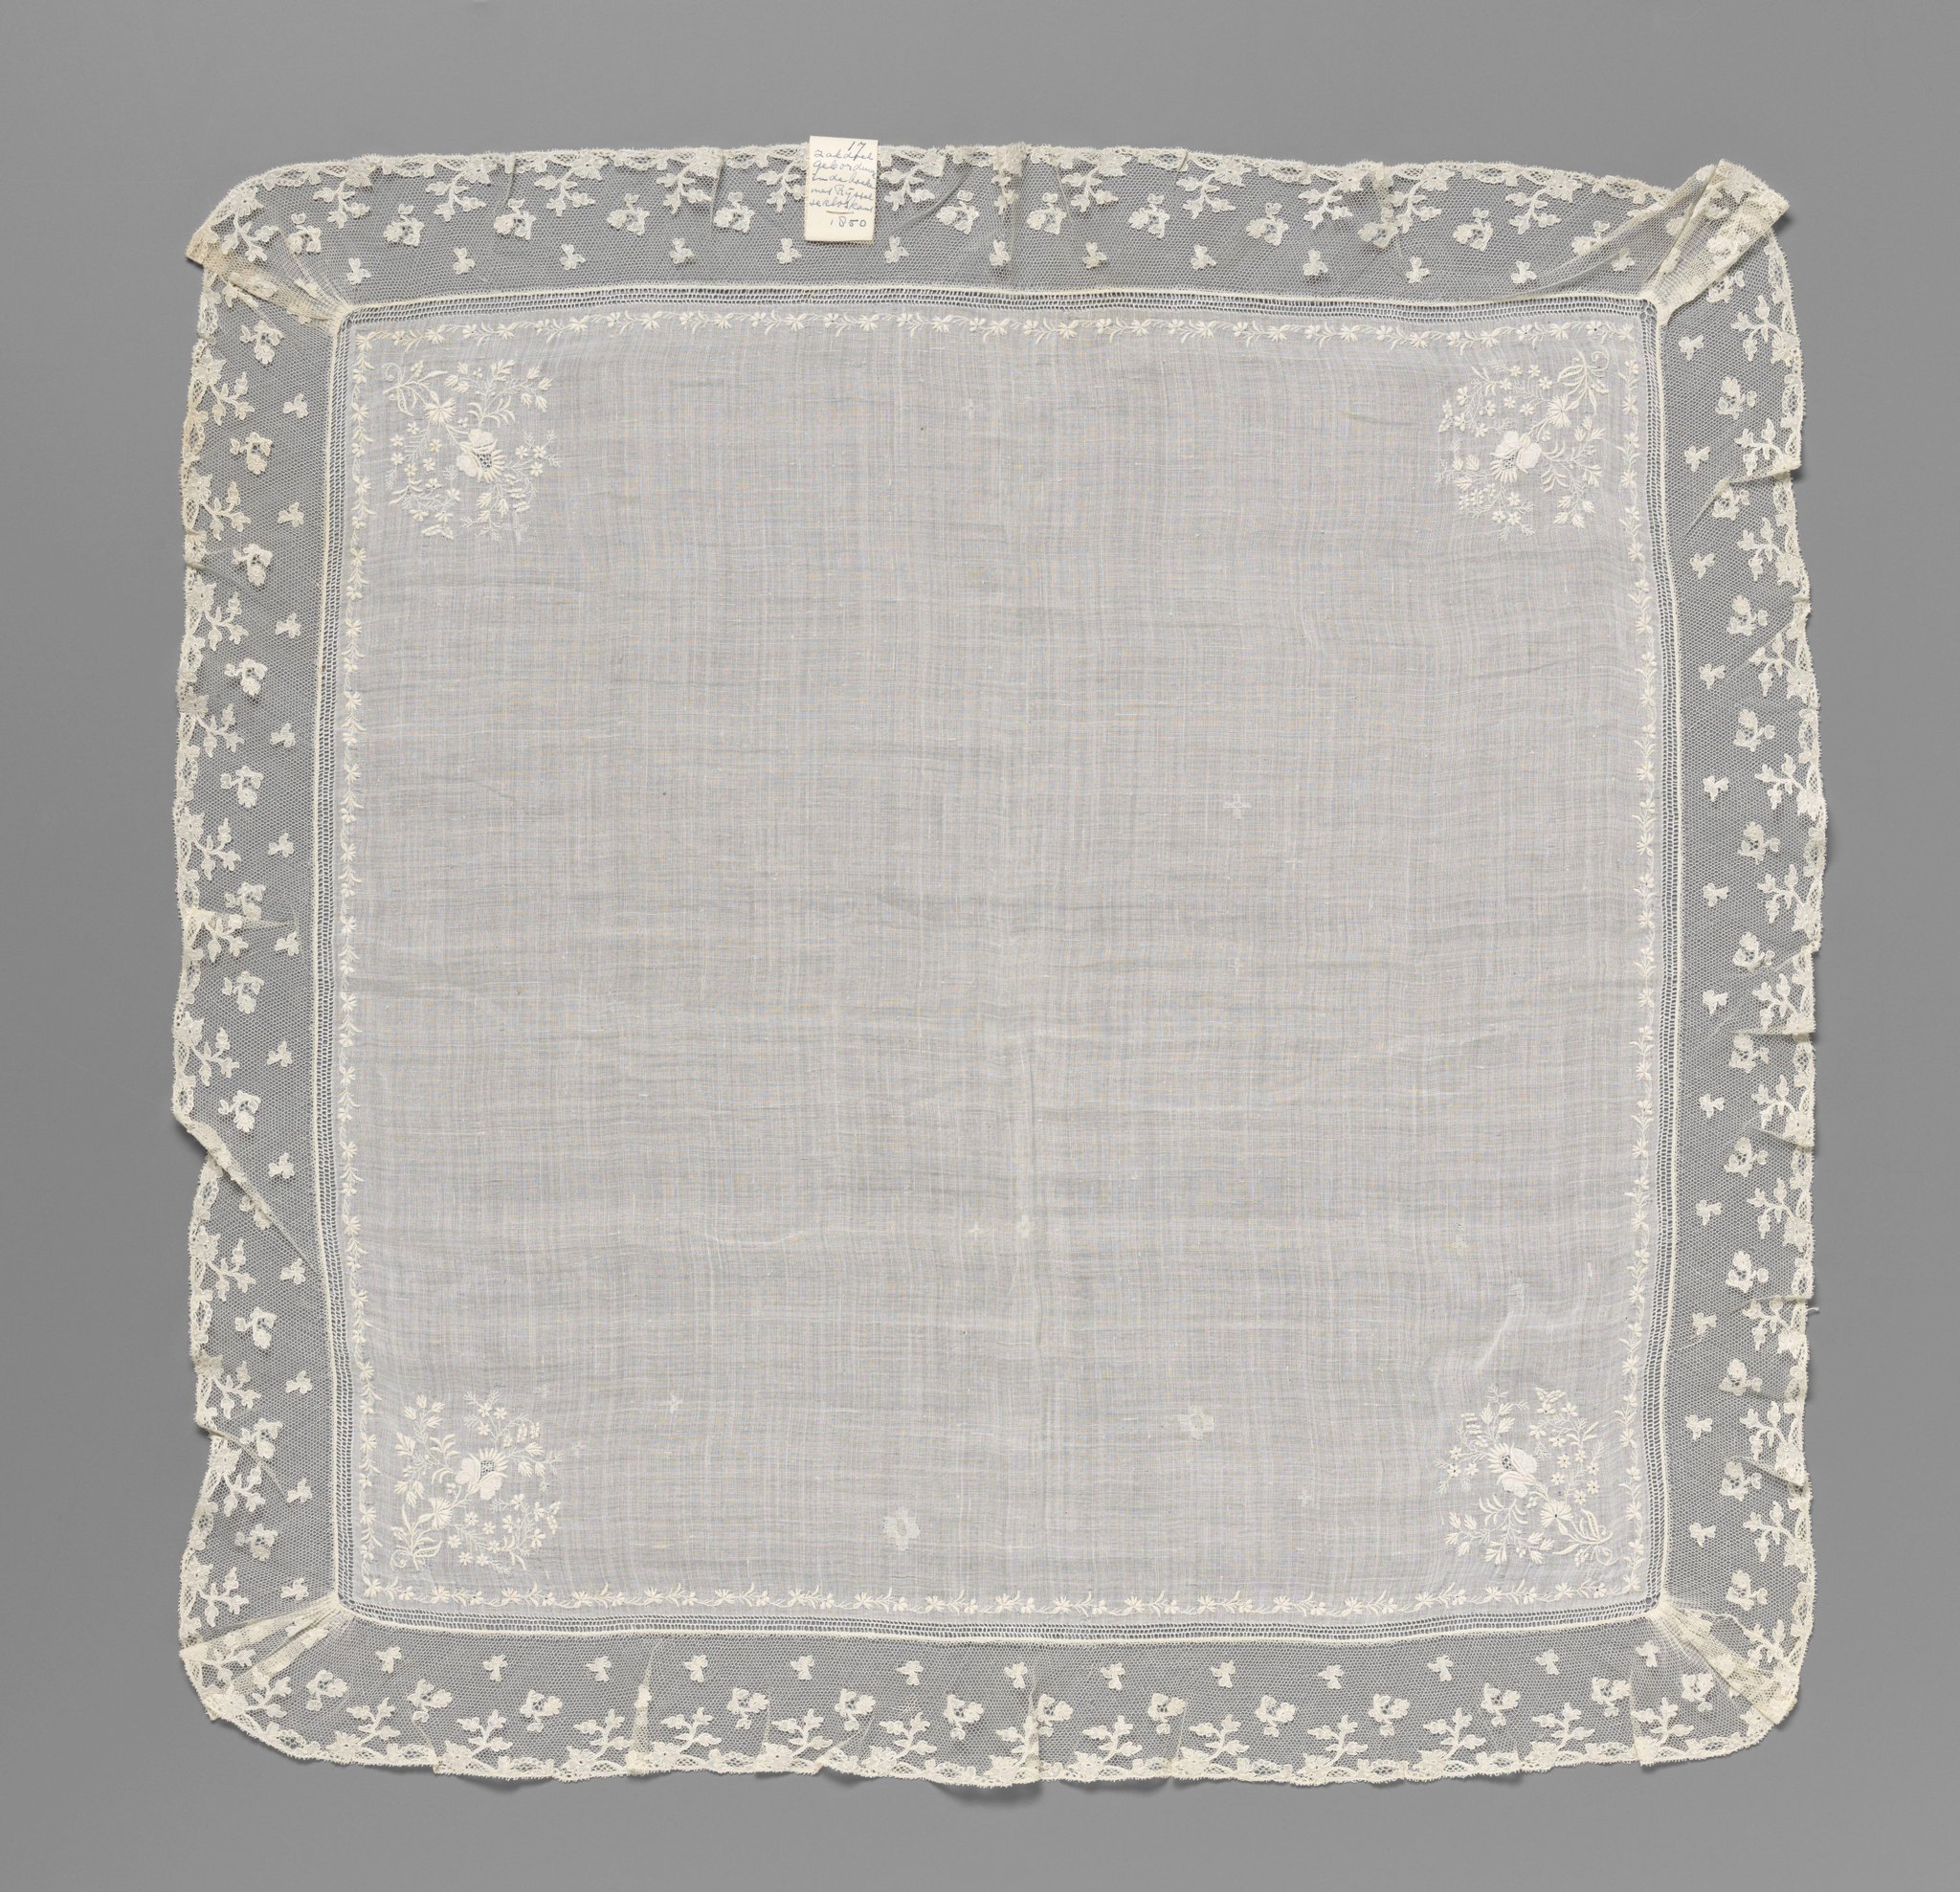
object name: handkerchief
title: Zakdoek van linnen batist met een rand kloskant en plumetis borduurwerk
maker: Anonymous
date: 1840-1849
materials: linen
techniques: lace, embroidered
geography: netherlands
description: Zakdoek van linnen batist met een rand kloskant - Rijselse kant - en plumetis borduurwerk. Het kant is glad aangezet langs de zijden en gerimpeld in de hoeken. Het heeft langs de buitenrand een vlakke gepicoteerde schulprand, die ontstaat uit een lopend patroon met een eenvoudig bloemtakje en met siergrond gevulde half ovale cartouches. Fijne maasgrond met volwerk in linnenslag en contourlijnen met een dikkere draad. Het plumetispatroon bestaat uit een fijne rank die rondom de zakdoek loopt en in elke hoek een boeket.